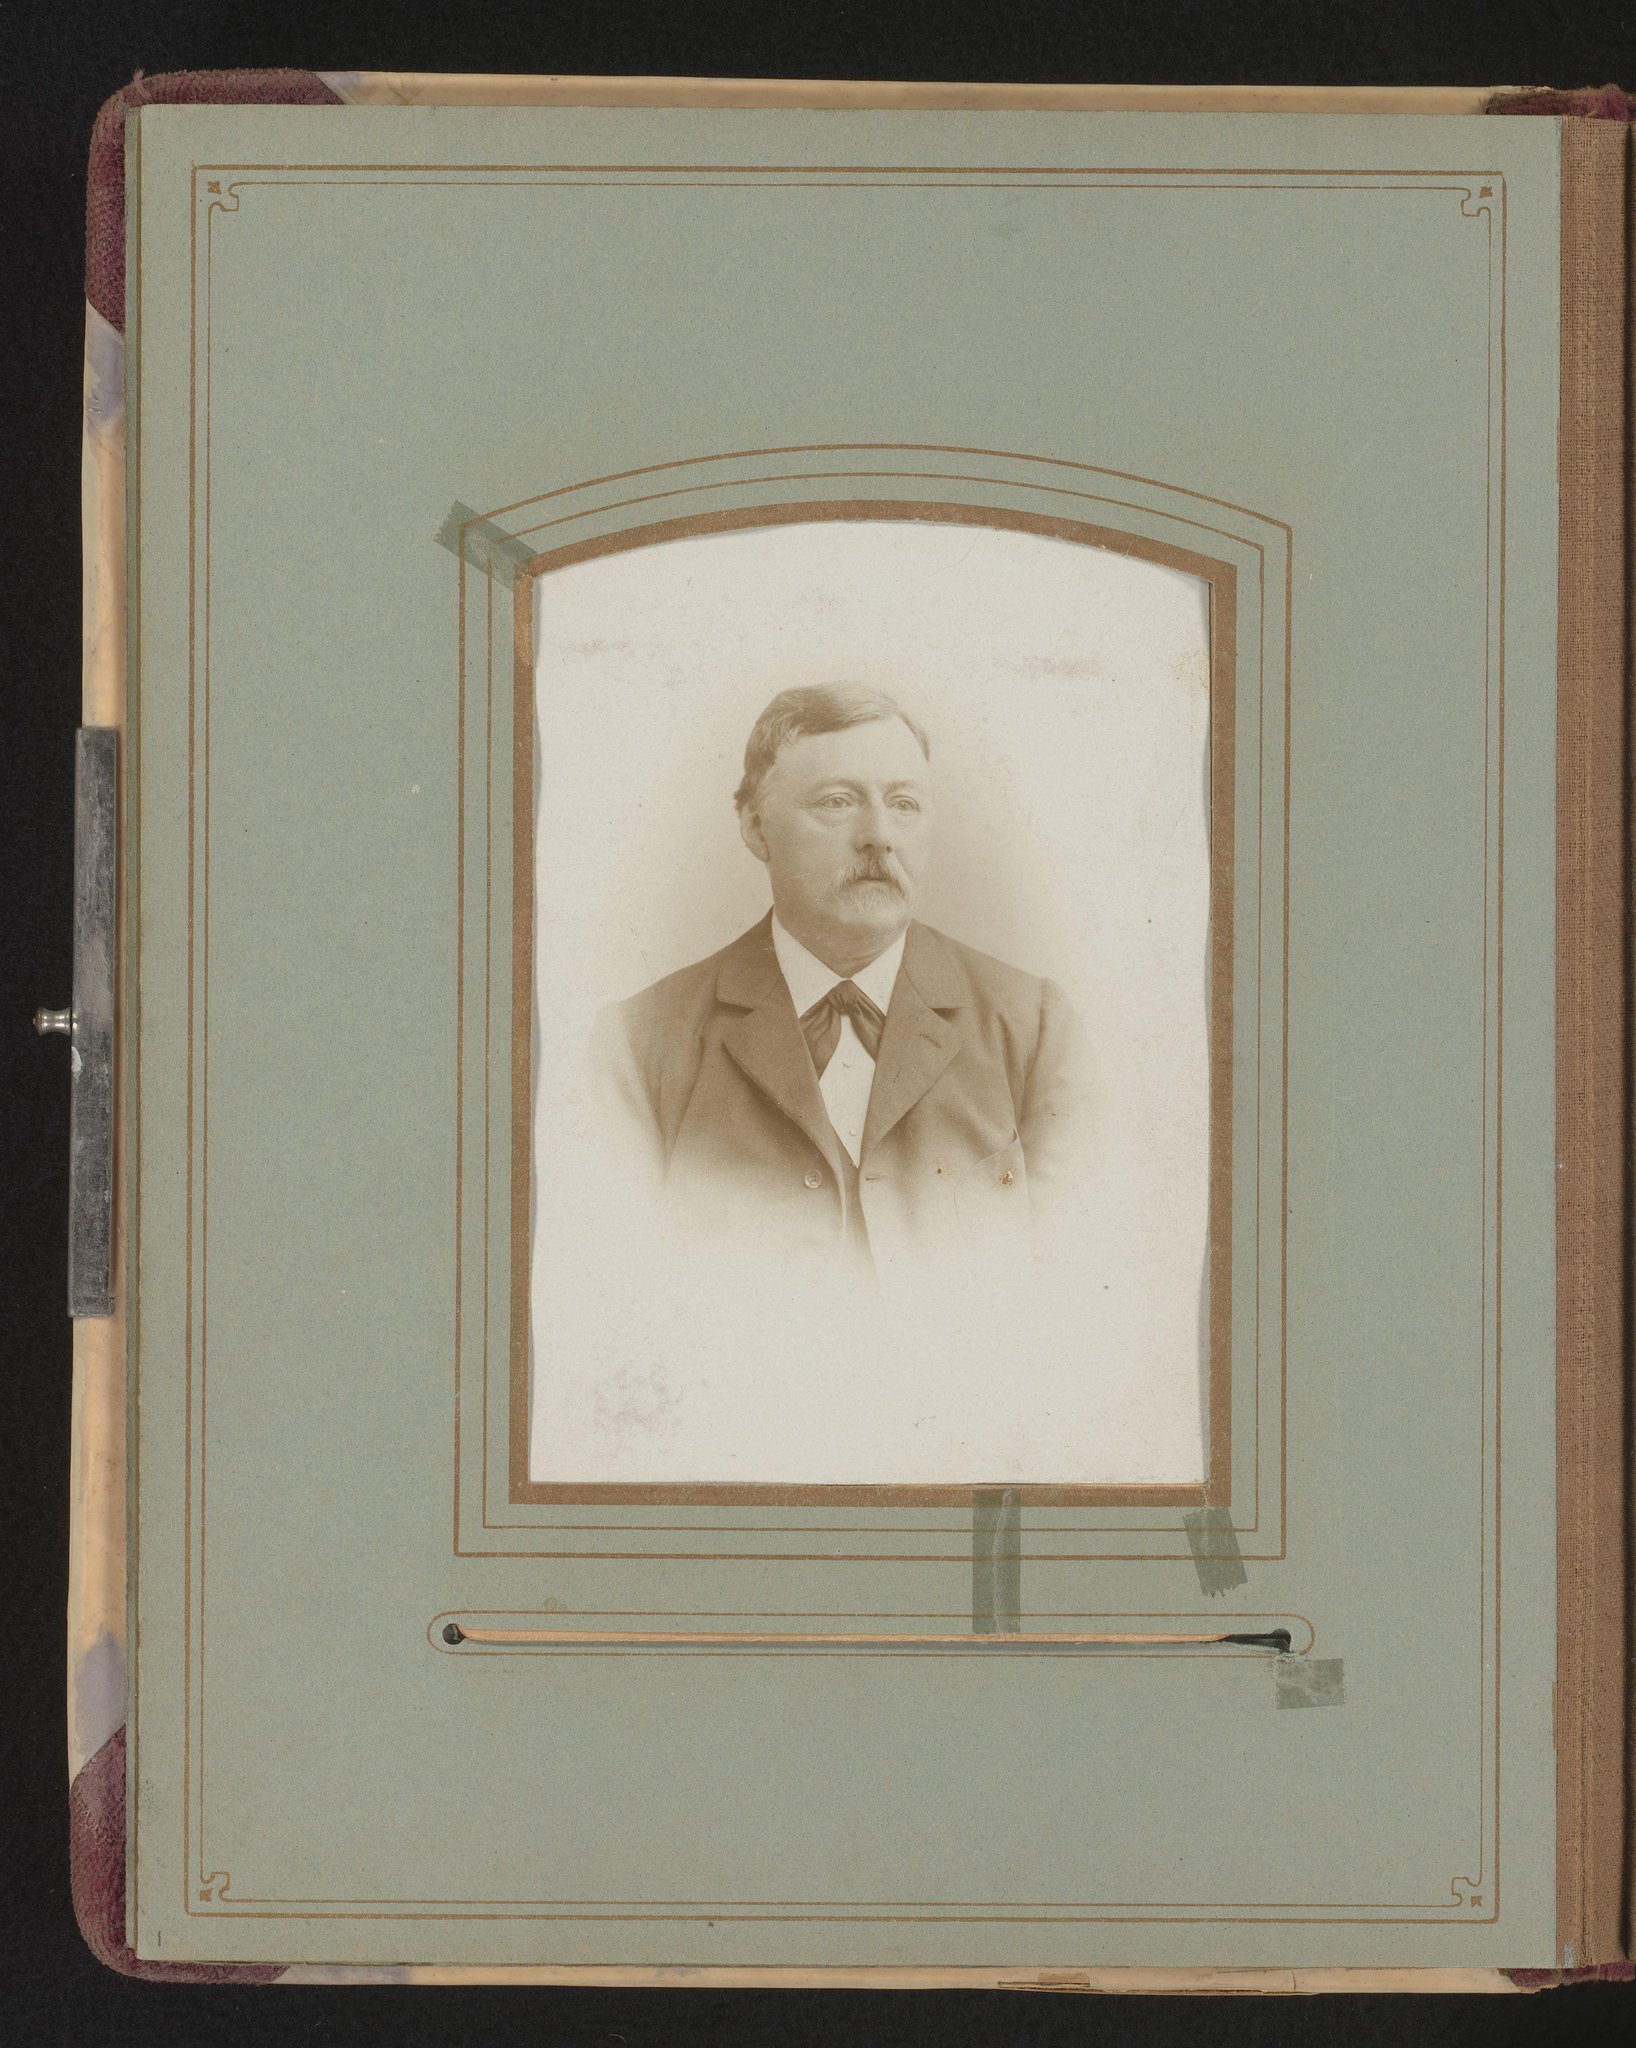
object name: album leaf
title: Portret van een man met snor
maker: p.d. van rhijn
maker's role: fotograaf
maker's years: 1874-1942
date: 1891-1896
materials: cardboard, photographic support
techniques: collodion silver print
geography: amsterdam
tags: moustache, historical persons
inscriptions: inscription: ‘Photographie/ Studio/ P. D. van Rhijn/ Damrak 42/ Utrechtschestraat 47/ Amsterdam./ Specialiteit in Vergrootingen/ en Kinderopname./ De plaat blijft ter nabestelling bewaard.’